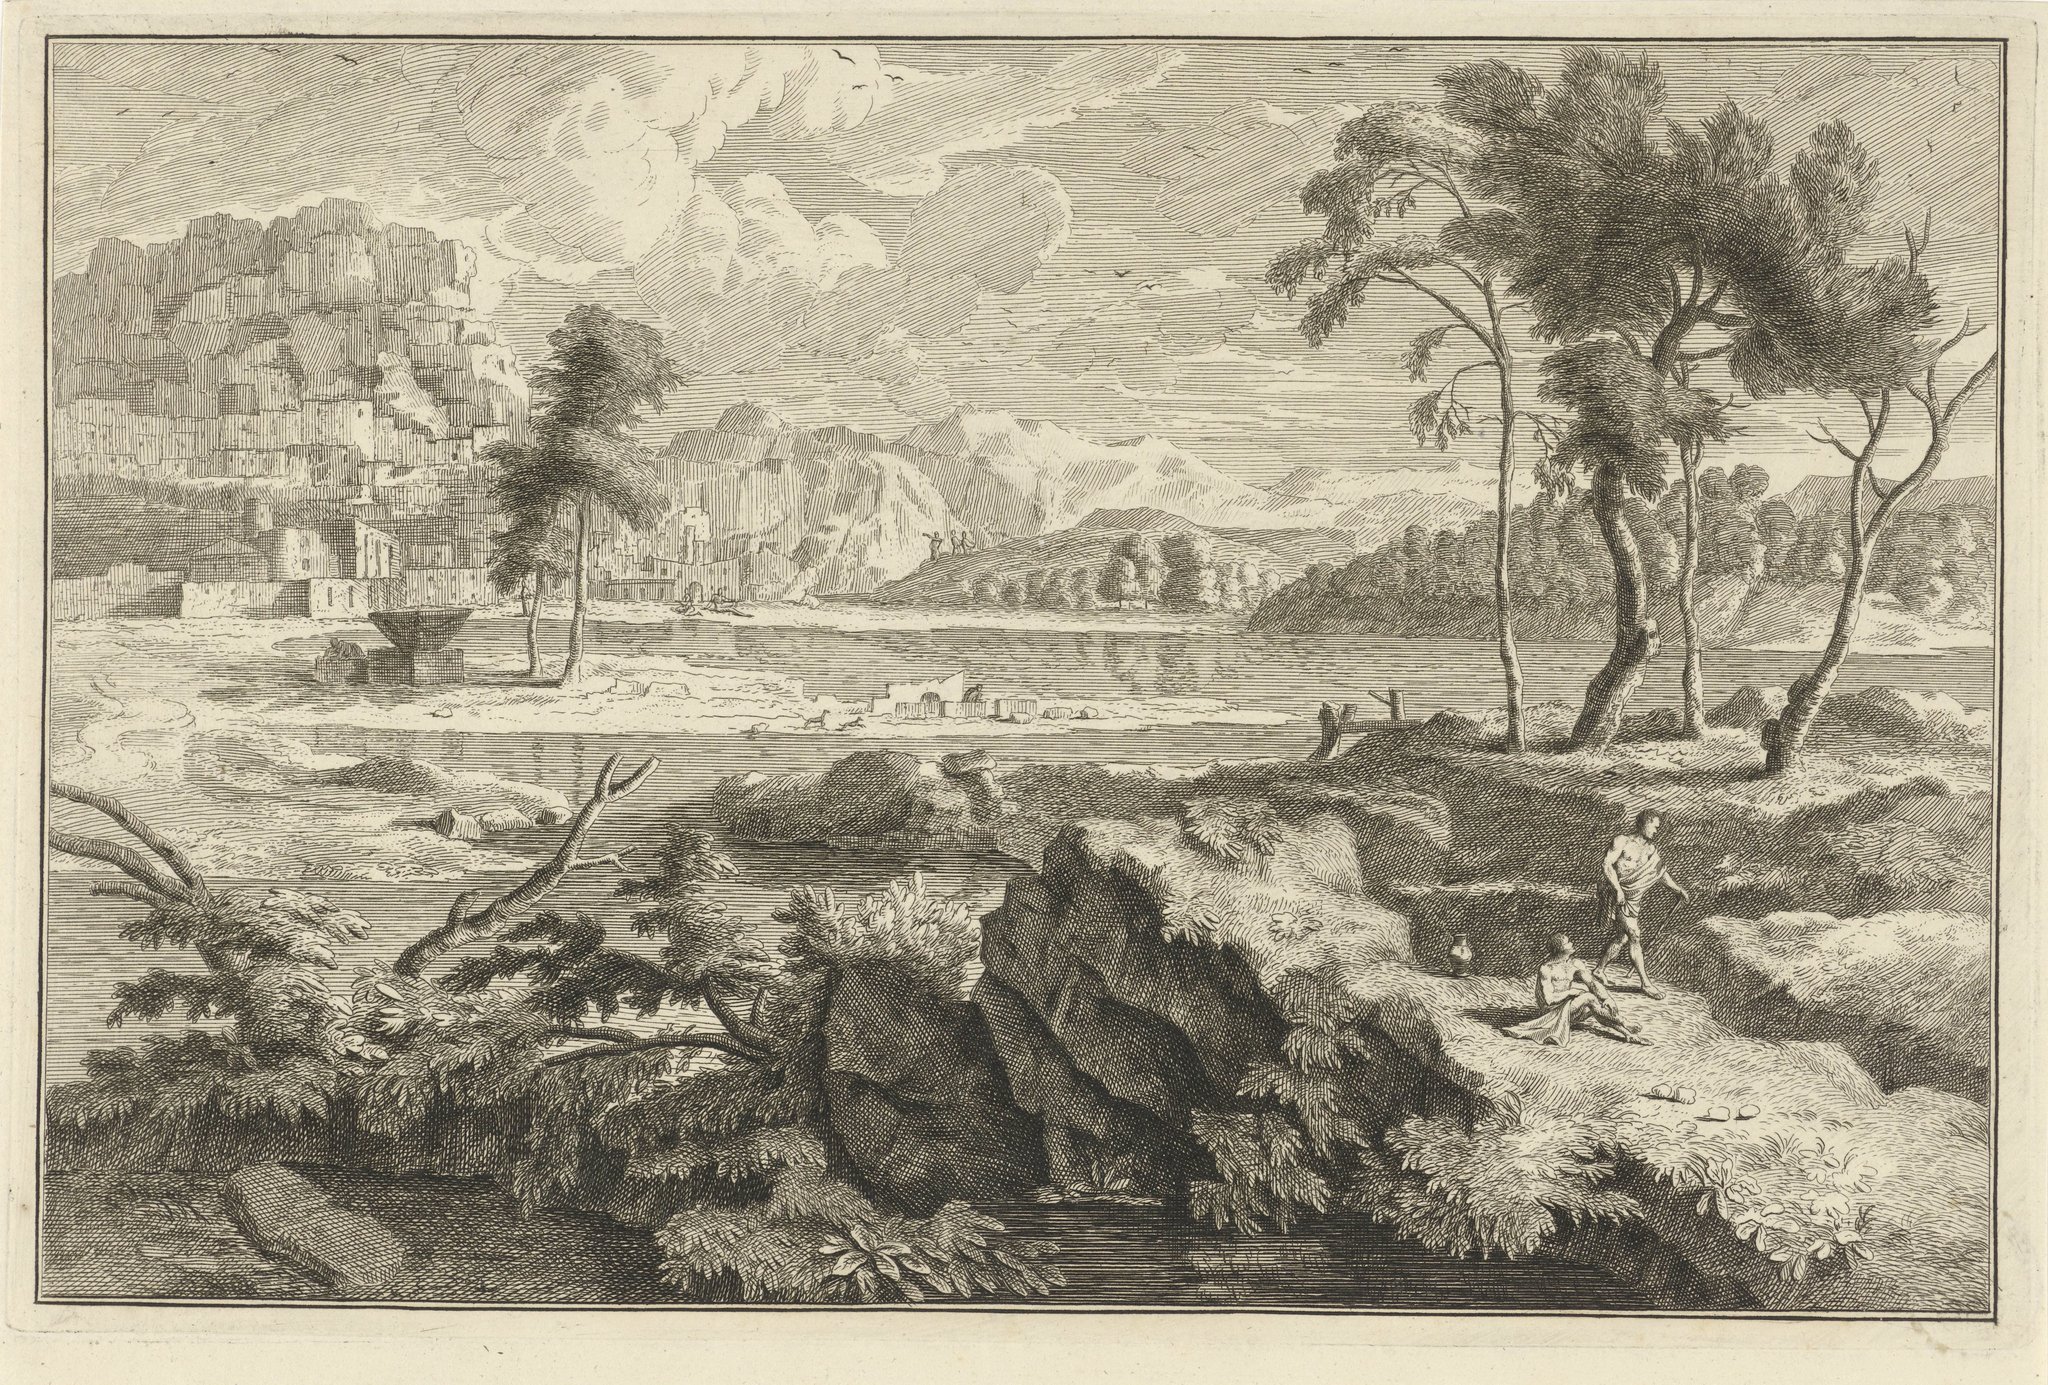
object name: print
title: Arcadisch landschap met rotsen en rivier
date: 1710-1747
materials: paper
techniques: etching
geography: amsterdam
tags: landscapes with waters, waterscapes, seascapes (in the temperate zone), prospect of city, town panorama, silhouette of city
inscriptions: collector's mark: Lugt 240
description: Arcadisch rivierlandschap met op de voorgrond rotsen, rechts twee mannen. In de verte een stad. De prent maakt deel uit van een 40-delige serie prenten met voorstellingen van Italiaanse en Duitse landschappen.